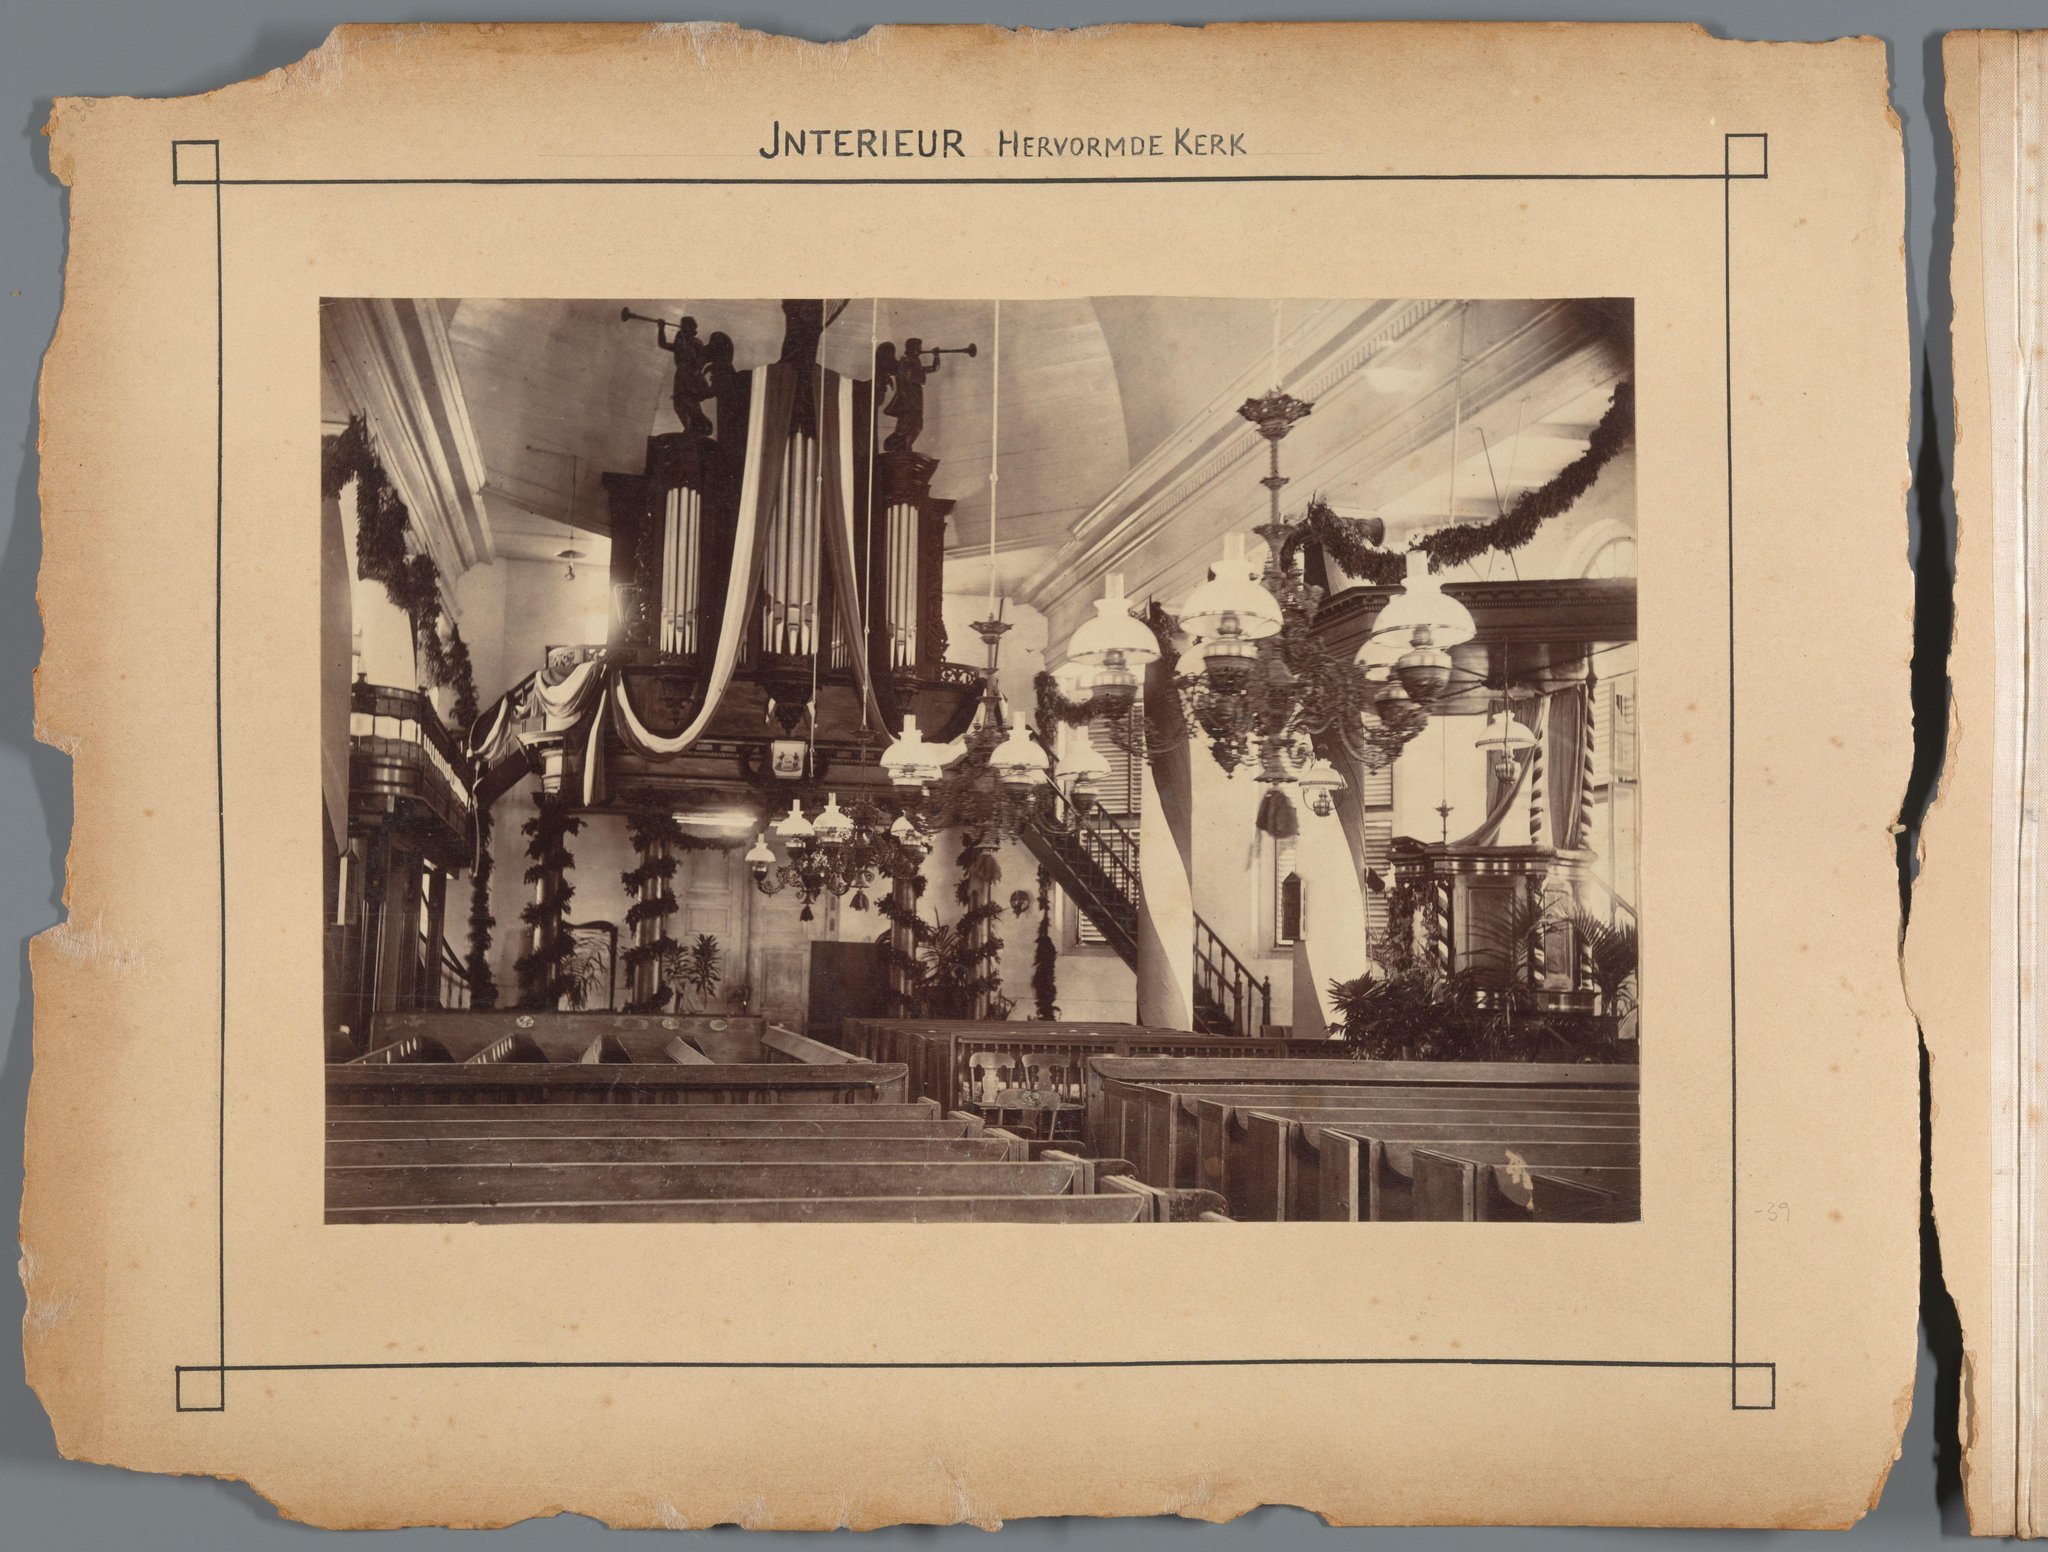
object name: photograph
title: Interieur hervormde kerk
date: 1898-1902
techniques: albumen print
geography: suriname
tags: interior of church, suriname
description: Interieur van de Hervormde kerk, of Centrumkerk, te Paramaribo.